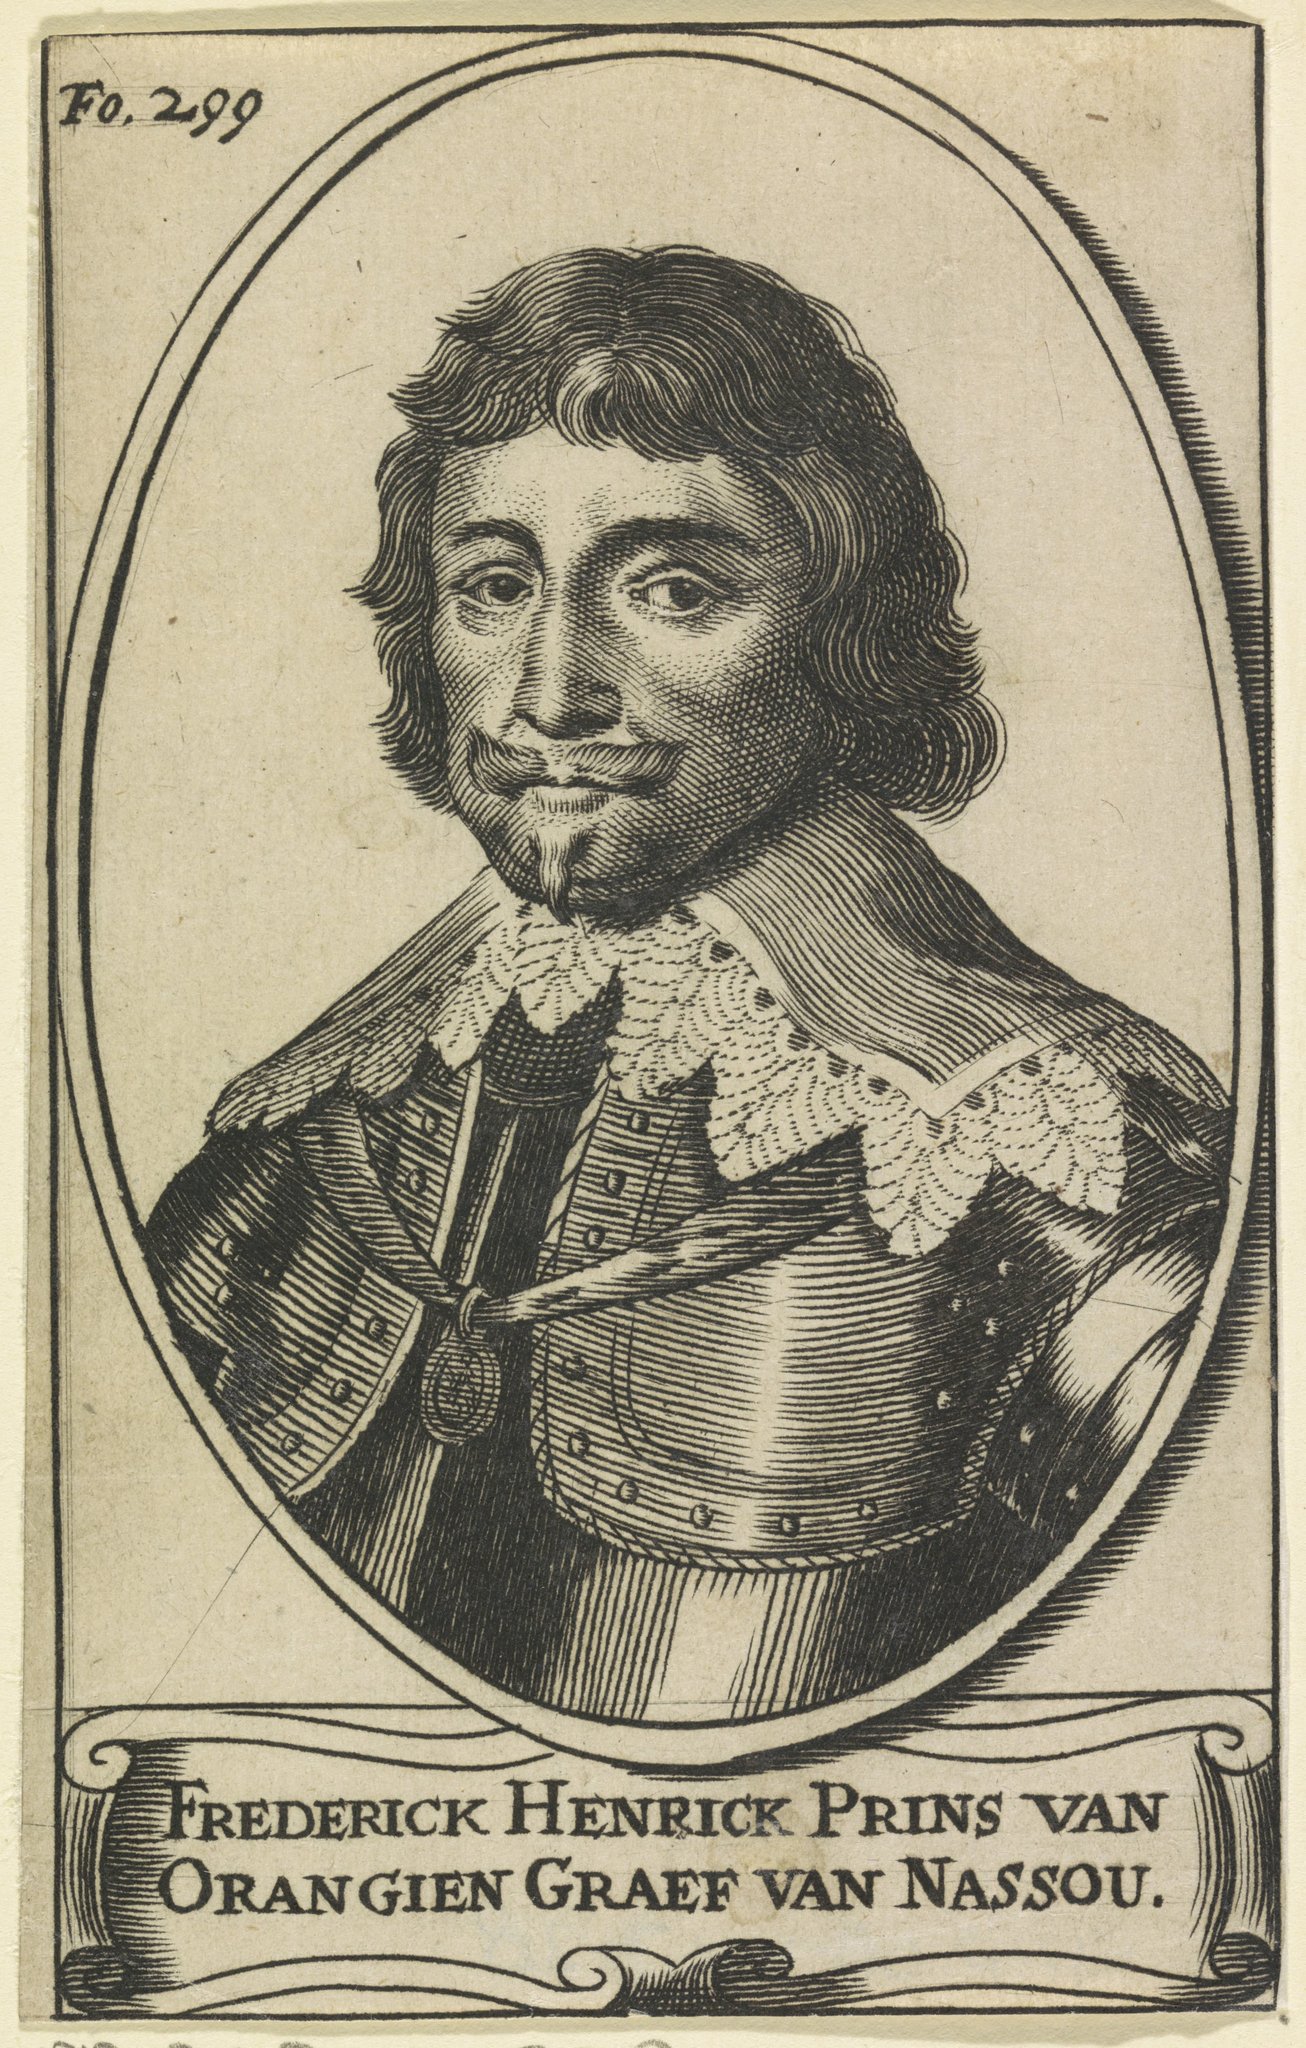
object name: print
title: Portret van Frederik Hendrik, prins van Oranje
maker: Anonymous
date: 1600-1699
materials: paper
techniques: engraving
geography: low countries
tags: delft, the hague, frederick henry (prince of orange), knighthood order (garter) - insignia of a knighthood order, e.g.: badge, chain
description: De hier vermelde titel verwijst naar de hoogst verkregen titel van de geportretteerde, niet per se naar de titel die de geportretteerde op deze voorstelling draagt.